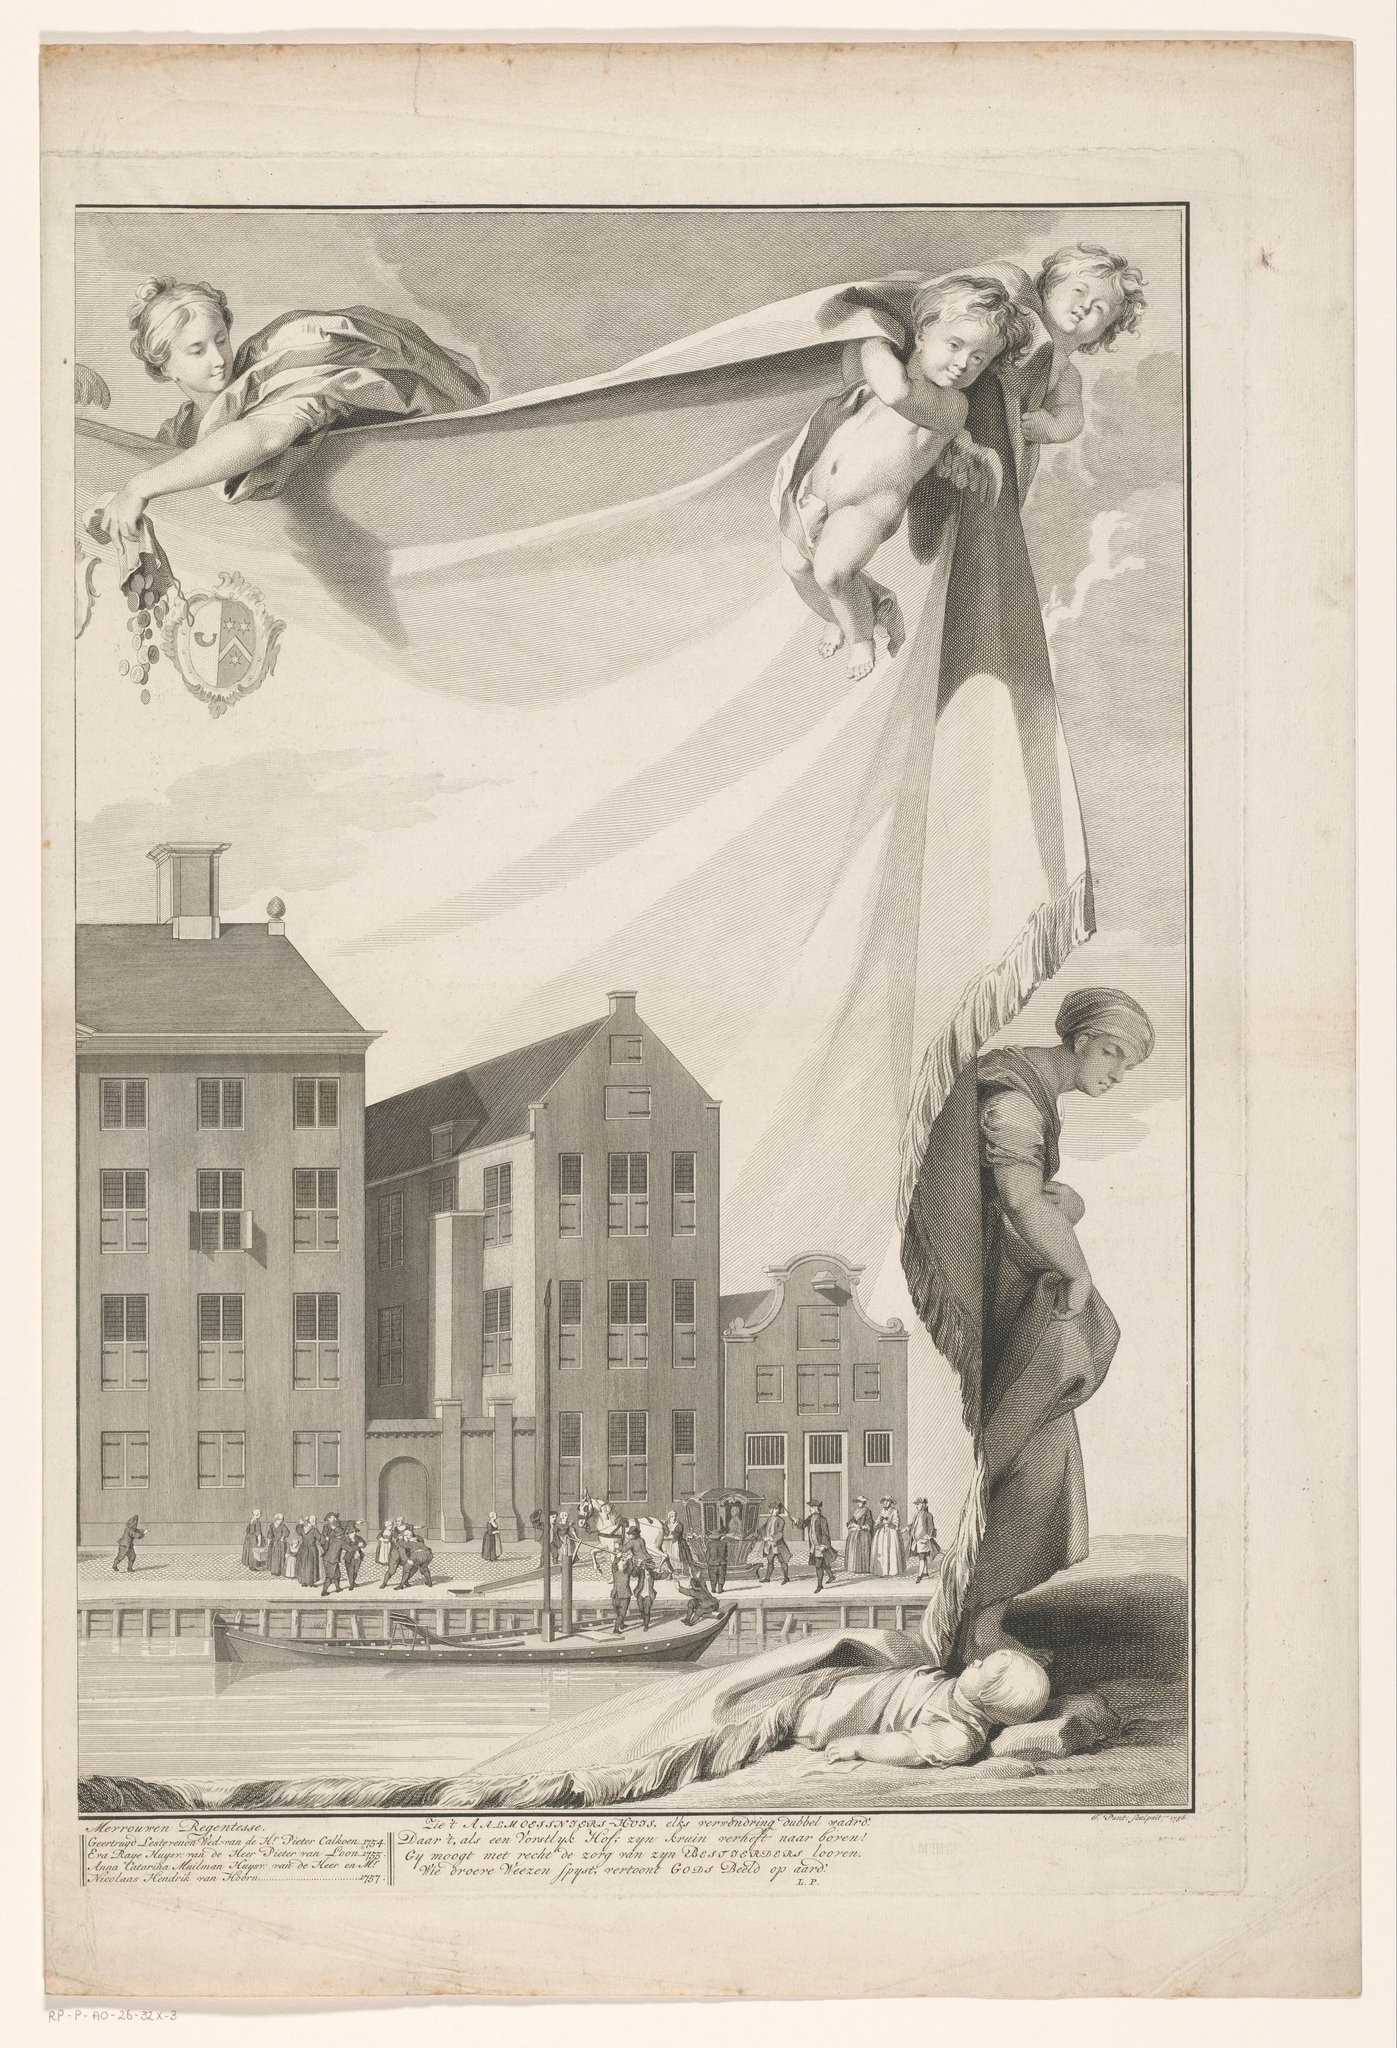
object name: print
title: Het Aalmoesseniers-Weezhuis te Amsteldam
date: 1758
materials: paper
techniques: engraving, etching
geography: amsterdam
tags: public welfare, foundling (and adoption), abandoning, exposing a child, orphanage, canals, waters (in city) (+ city(-scape) with figures, staffage), armorial bearing, heraldry, street (+ city(-scape) with figures, staffage)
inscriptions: check stamp: ‘Archief Ministerie van Oorlog Afdeeling Genie’, collector's mark: Lugt 2228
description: Rechterdeel van een gezicht op het Aalmoezeniersweeshuis te Amsterdam, bestaande uit drie delen.